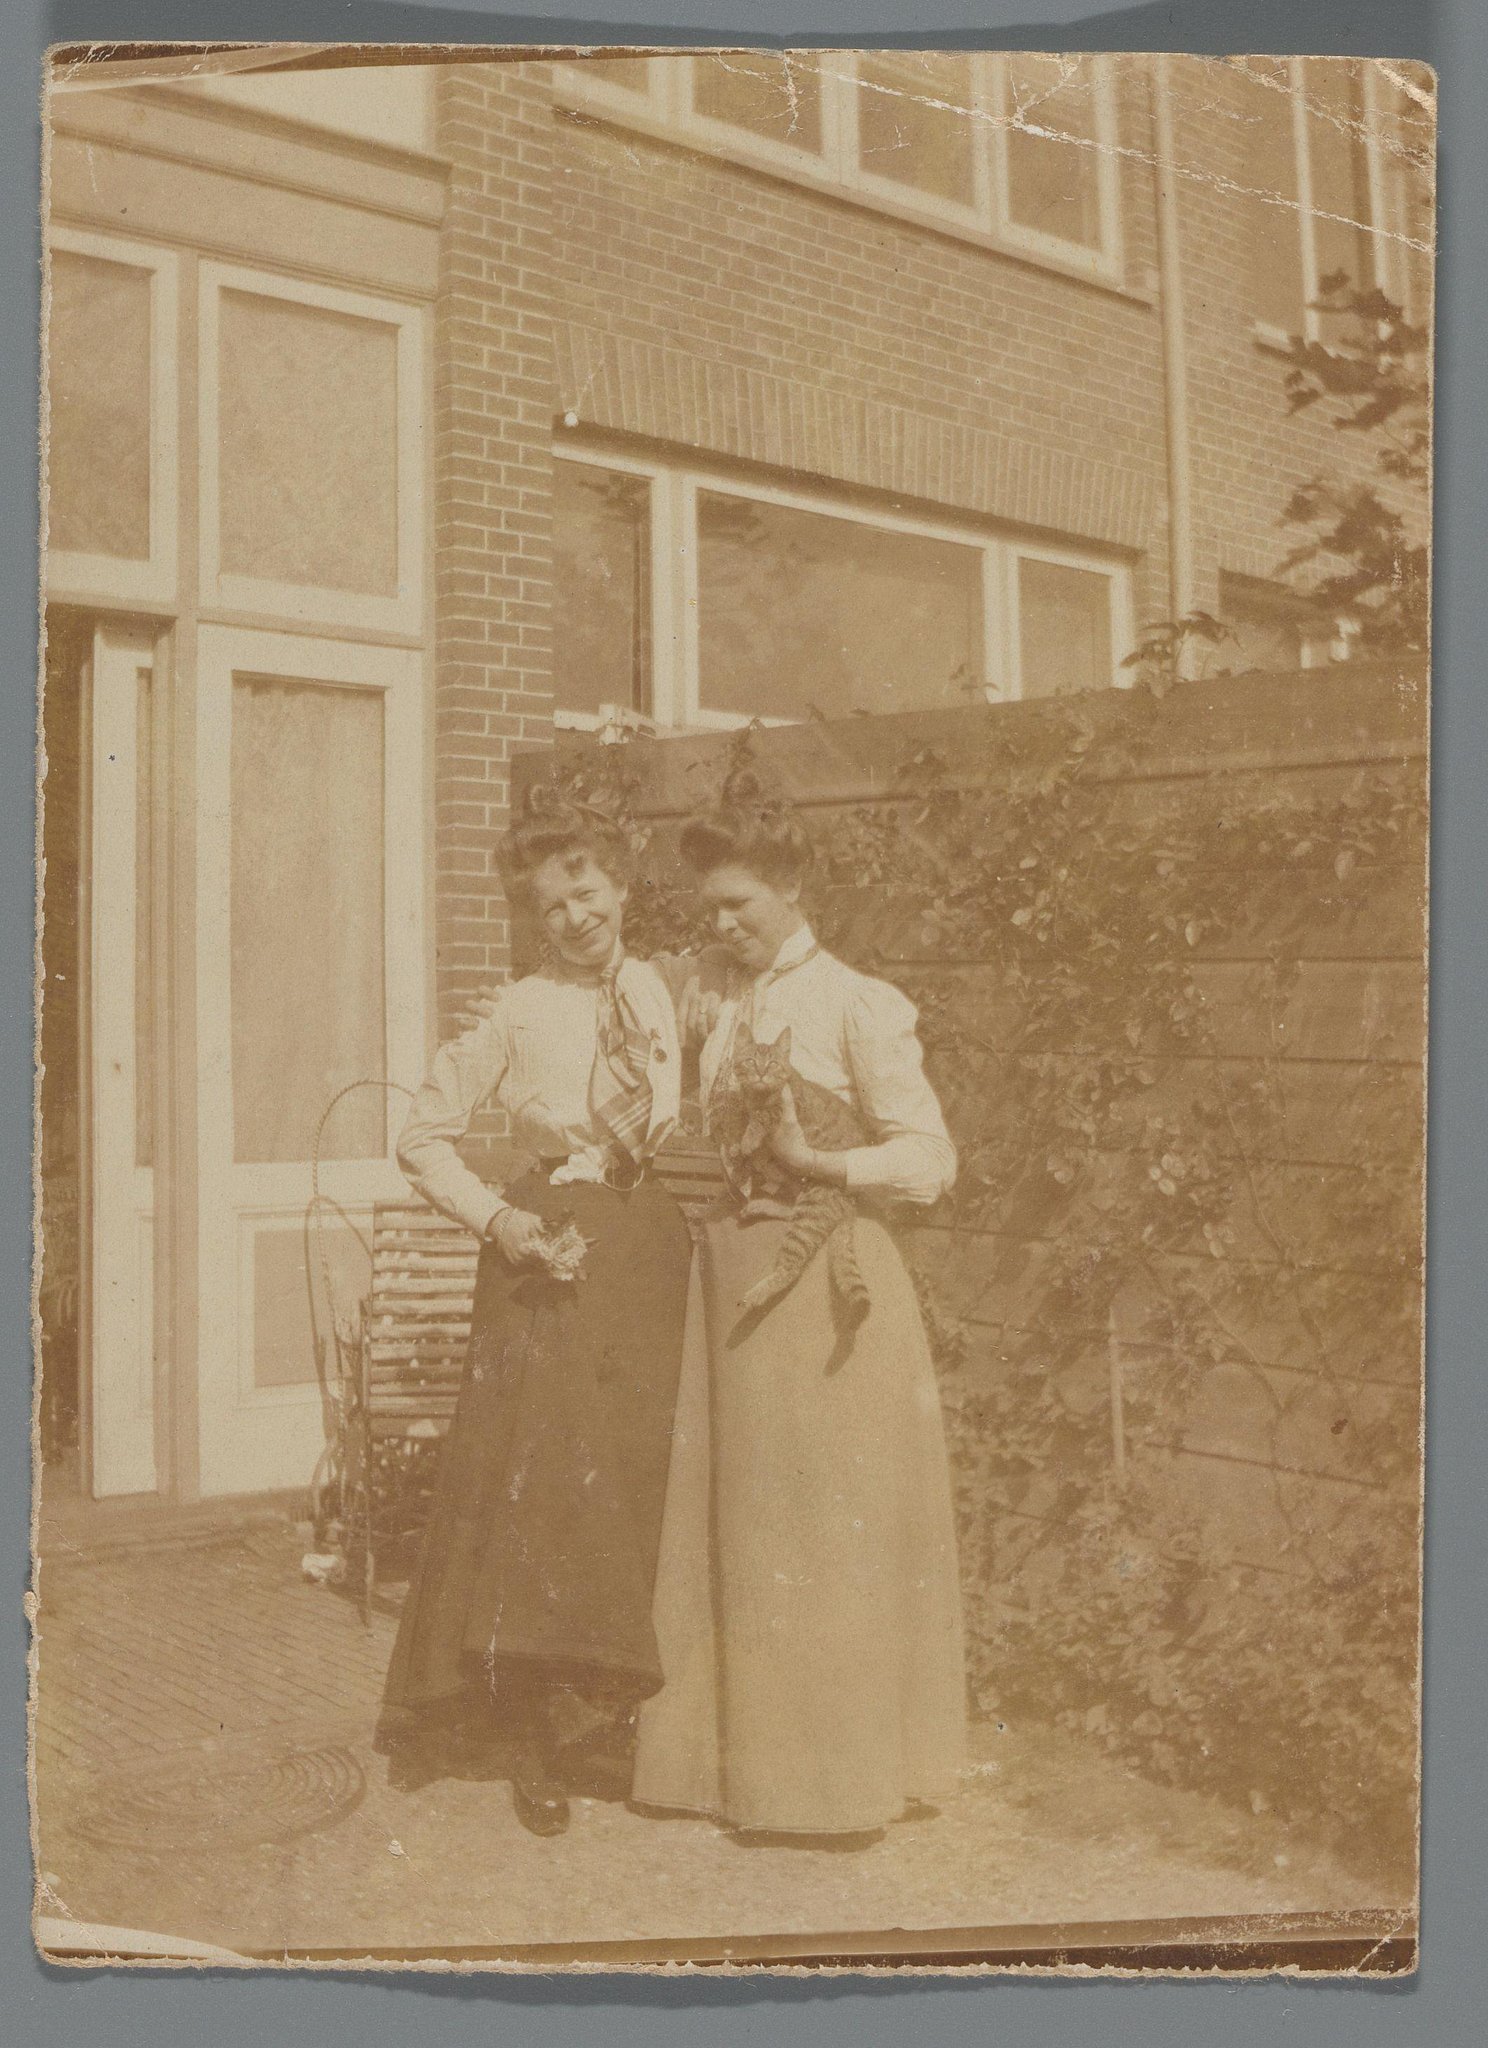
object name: photograph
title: Leo en Jeanne van den Berg, staand in achtertuin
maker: Anonymous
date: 1890-1914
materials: photographic support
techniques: albumen print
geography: the hague